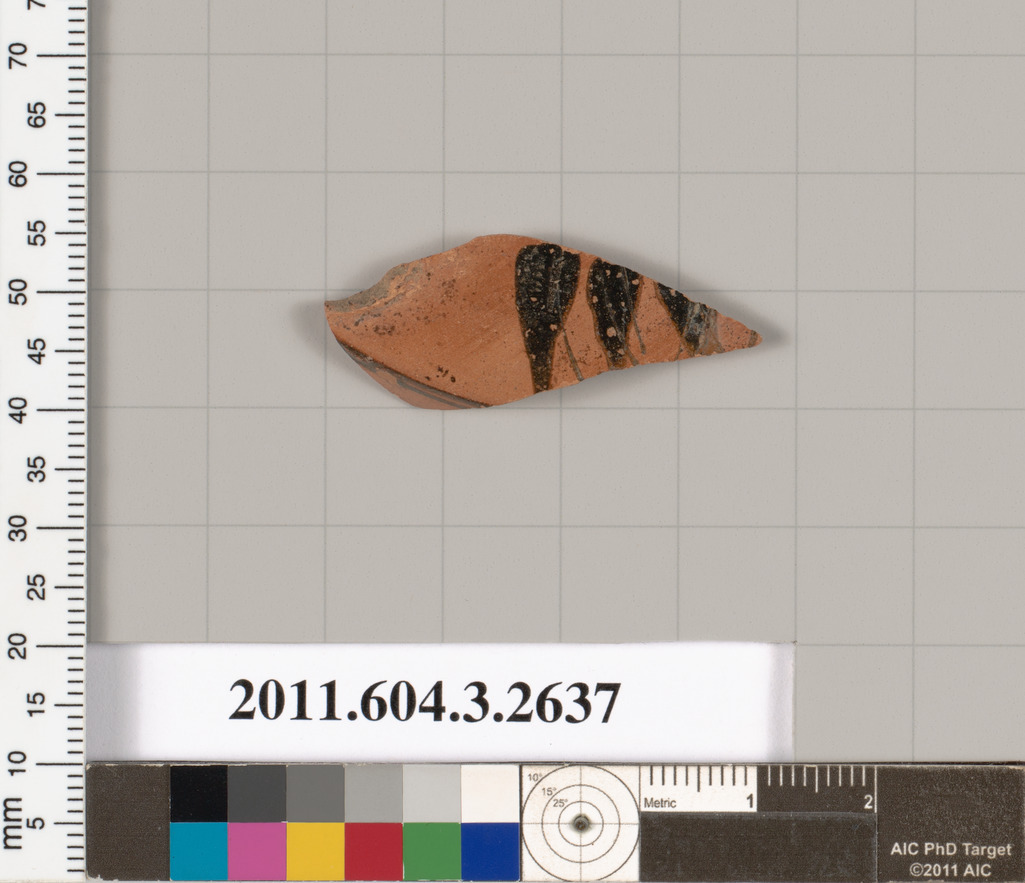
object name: lekythos fragment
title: Terracotta fragment of a lekythos (oil flask)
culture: greek, attic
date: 534-468 BCE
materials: terracotta